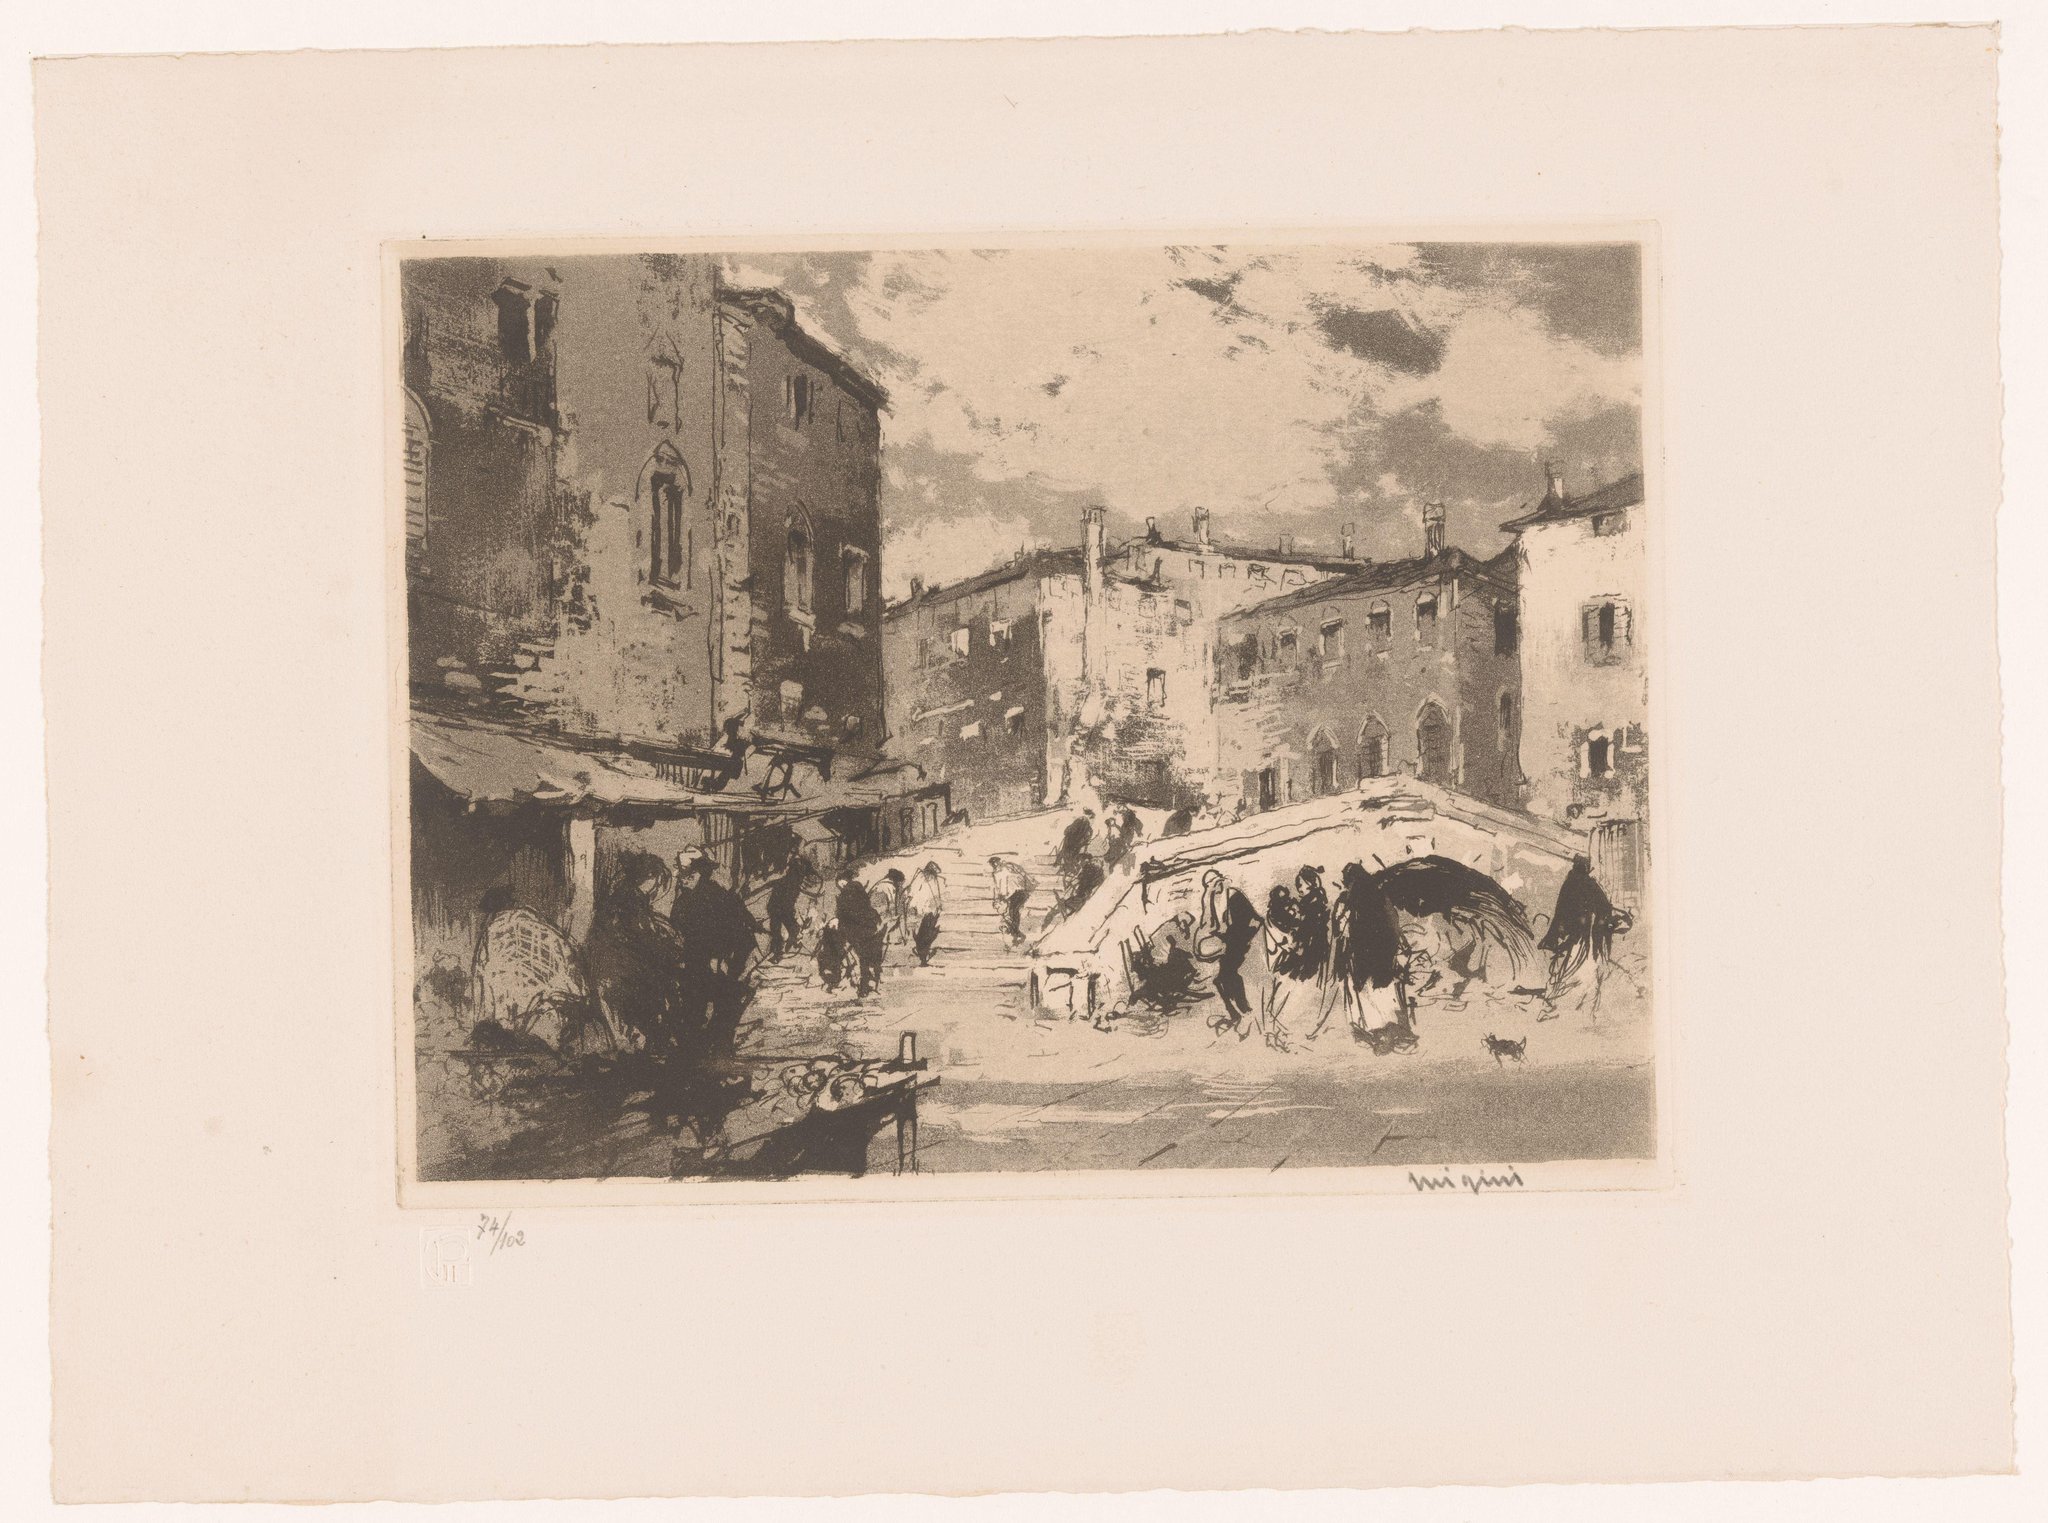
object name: print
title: Gezicht op Venetië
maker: ferdinand luigini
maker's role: print maker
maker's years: 1870-1943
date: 1930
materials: paper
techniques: aquatint, etching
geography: venice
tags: city-view in general; 'veduta', venice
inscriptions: collector's mark: Lugt 2228, check stamp: Lugt 1195a